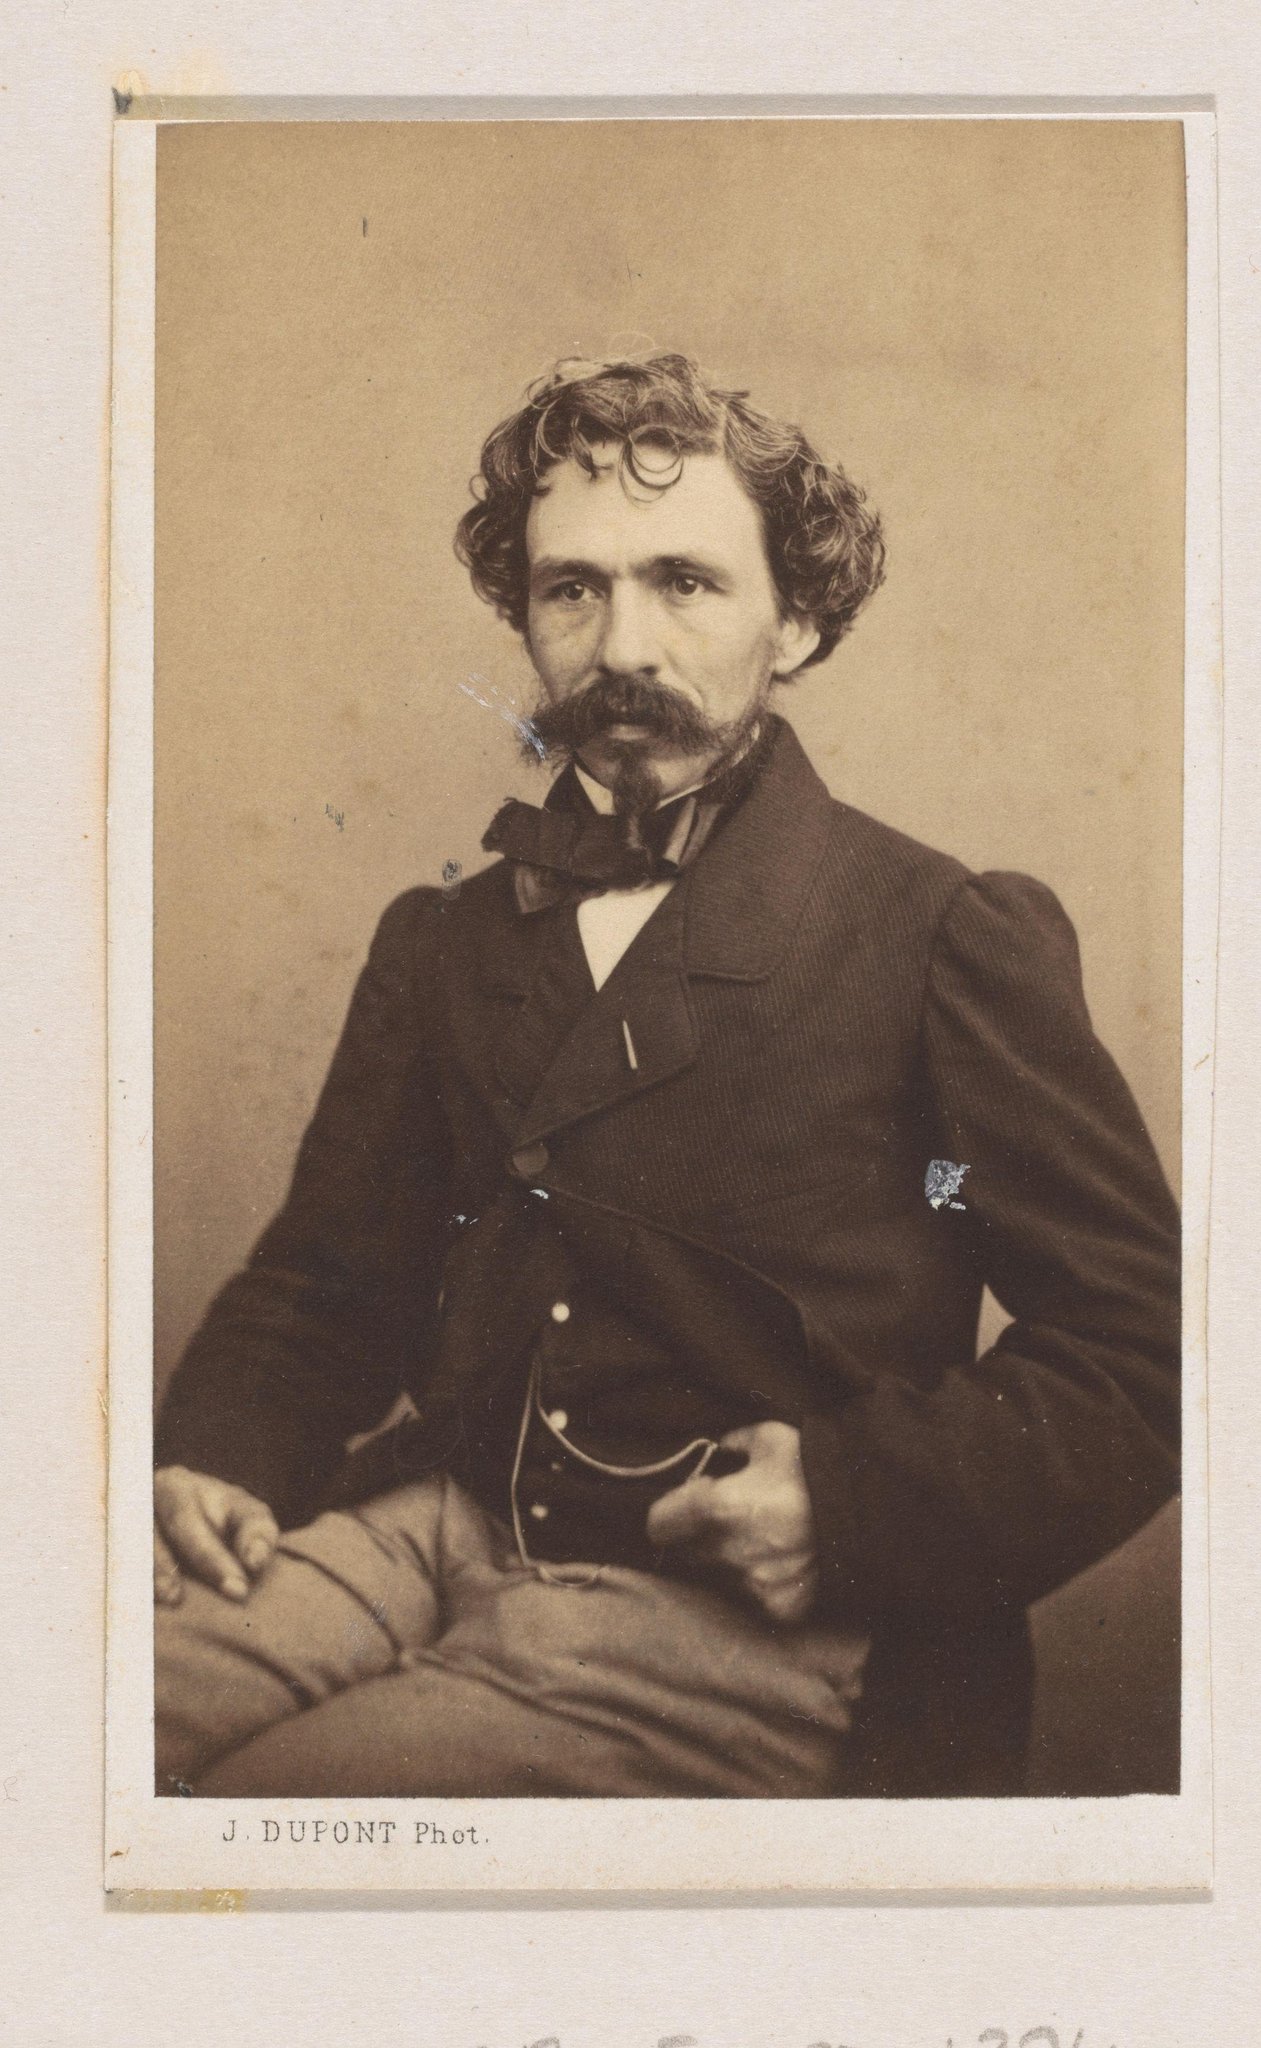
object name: photograph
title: Portret van de schilder Jozeph Lies, halffiguur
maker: joseph dupont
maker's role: fotograaf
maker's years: 1818-1901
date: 1861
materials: cardboard, paper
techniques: albumen print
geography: antwerp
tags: antwerp, painter, print maker, joseph lies, historical persons, portrait, self-portrait of painter, portrait, self-portrait of artist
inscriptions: inscription: ‘ETABLISSEMENT PHOTOGRAPHIQUE/ de/ J. DUPONT/ Place de Meir 32/ ANVERS/ Maison fondée en 1853’